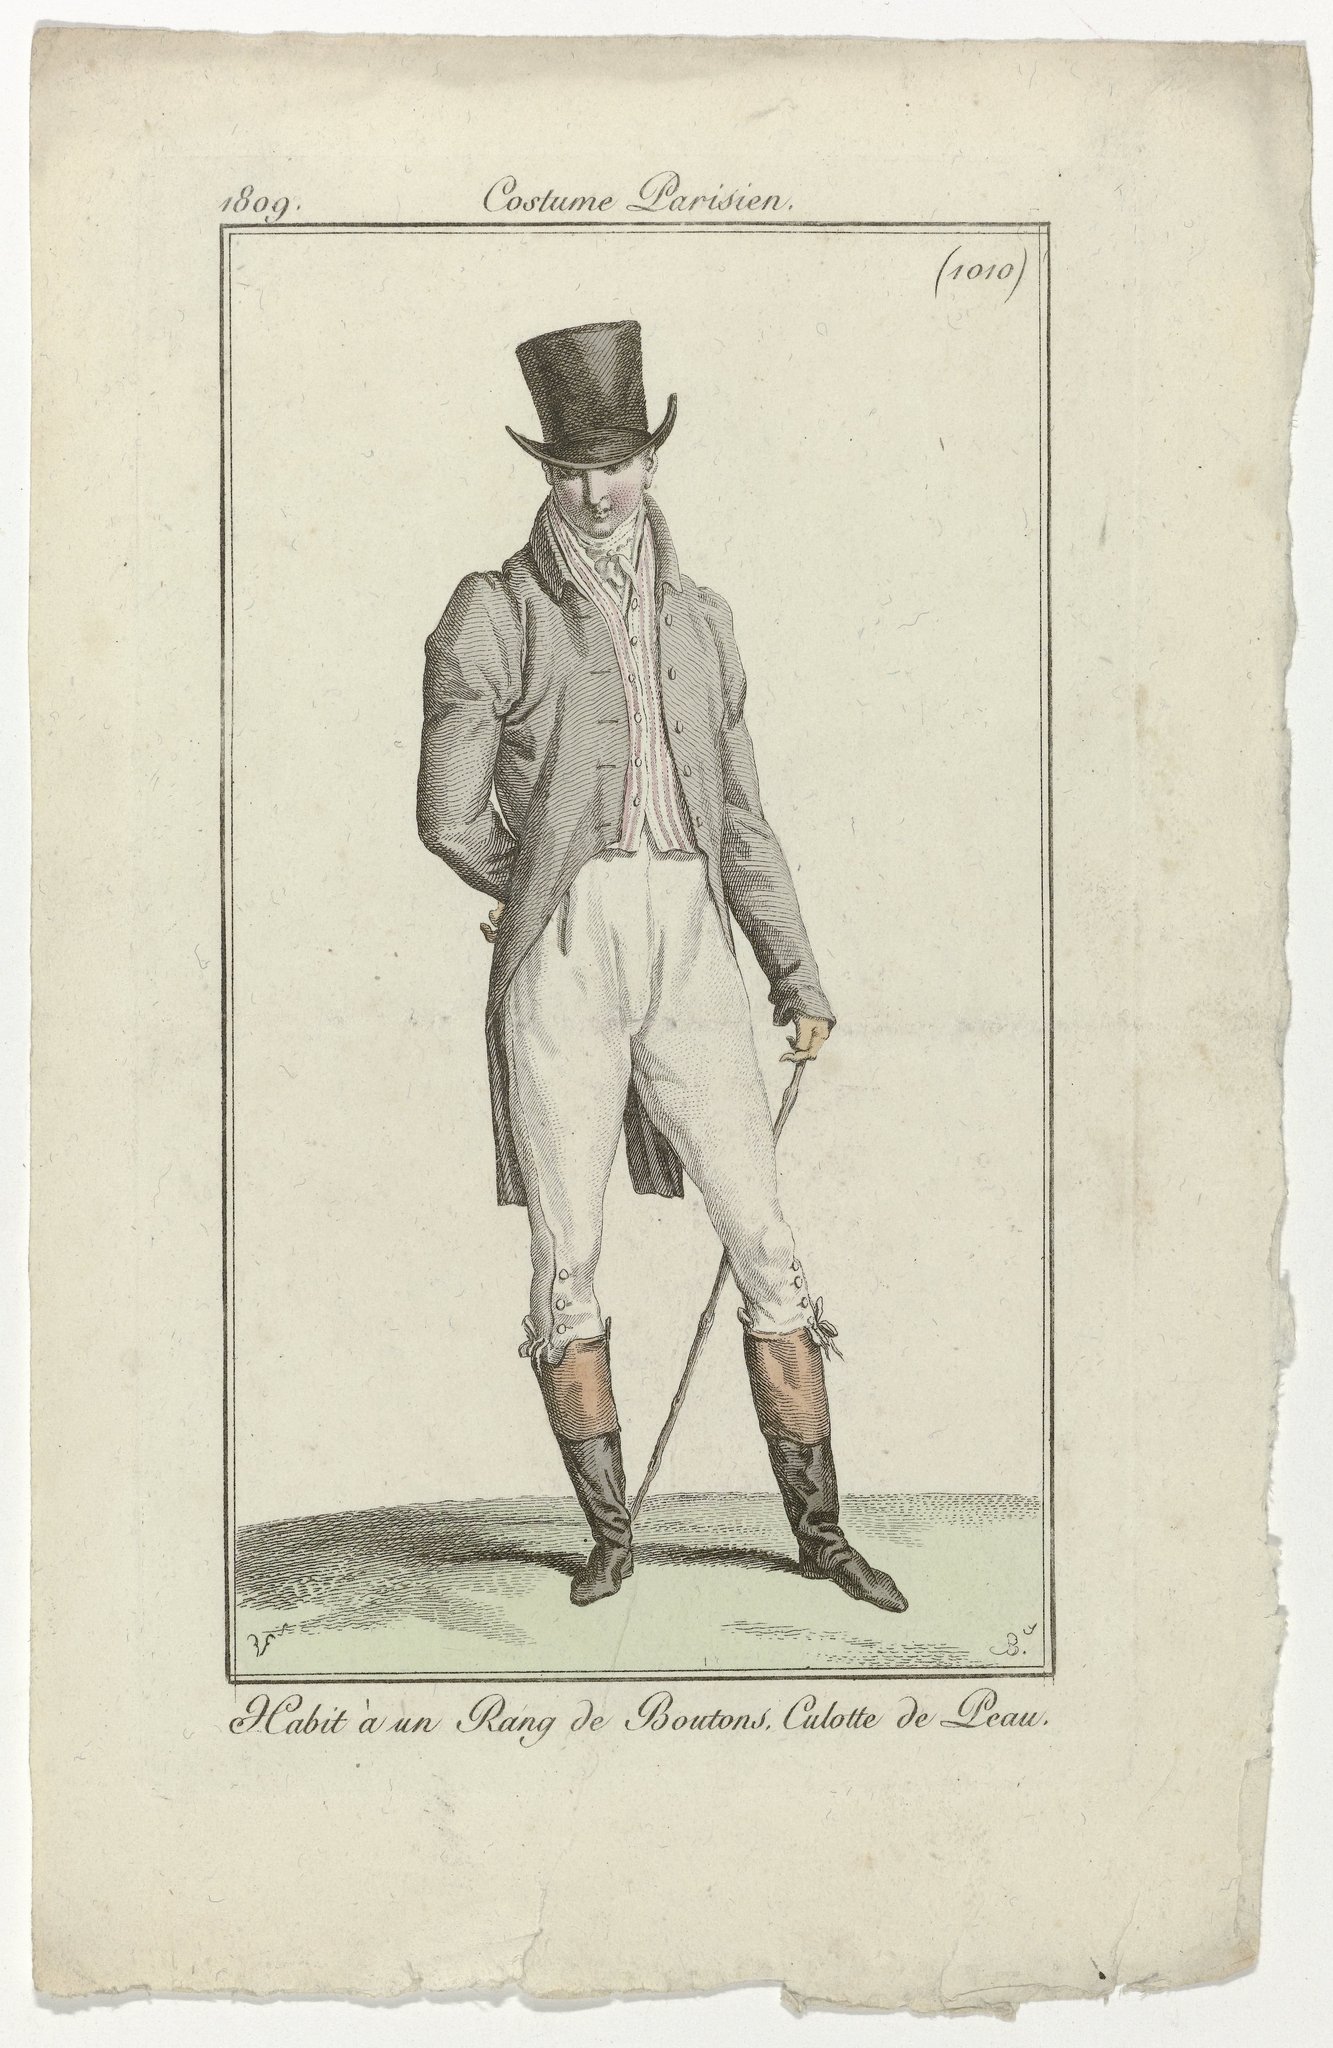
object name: fashion print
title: Journal des Dames et des Modes: Men’s Fashion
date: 1809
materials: paper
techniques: engraving, hand coloring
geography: paris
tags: clothing for the upper part of the body (vest) (+ men's clothes), neck-gear ~ clothing (cravat) (+ men's clothes), coat (+ men's clothes), fashion plates, trousers, breeches, etc. (breeches) (+ men's clothes), boots (+ men's clothes), gloves, mittens, etc. (+ men's clothes)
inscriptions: title: ‘Costume Parisien.’, caption: ‘Habit à un Rang de Boutons. Culotte de Peau.’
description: The Journal des Dames et des Modes occasionally provided coverage of men’s styles. These illustrations give a good picture of trends in mens’ clothing from 1797 to 1825. During the 18th century, gentlemen wore culotte (knee-breeches) 1. These fell out of fashion with the elimination of strict class distinctions during the French Revolution, to be replaced by a type of long trouser(s) known as pantalon à la Hussarde 2. These were worn with hussar boots. ‘Pantaloons’ 3 were trousers pulled tight with an elastic strap under the instep. Carrick 4 coats with a double collar were popular, and in the evenings men wore a special dress cloak 5.